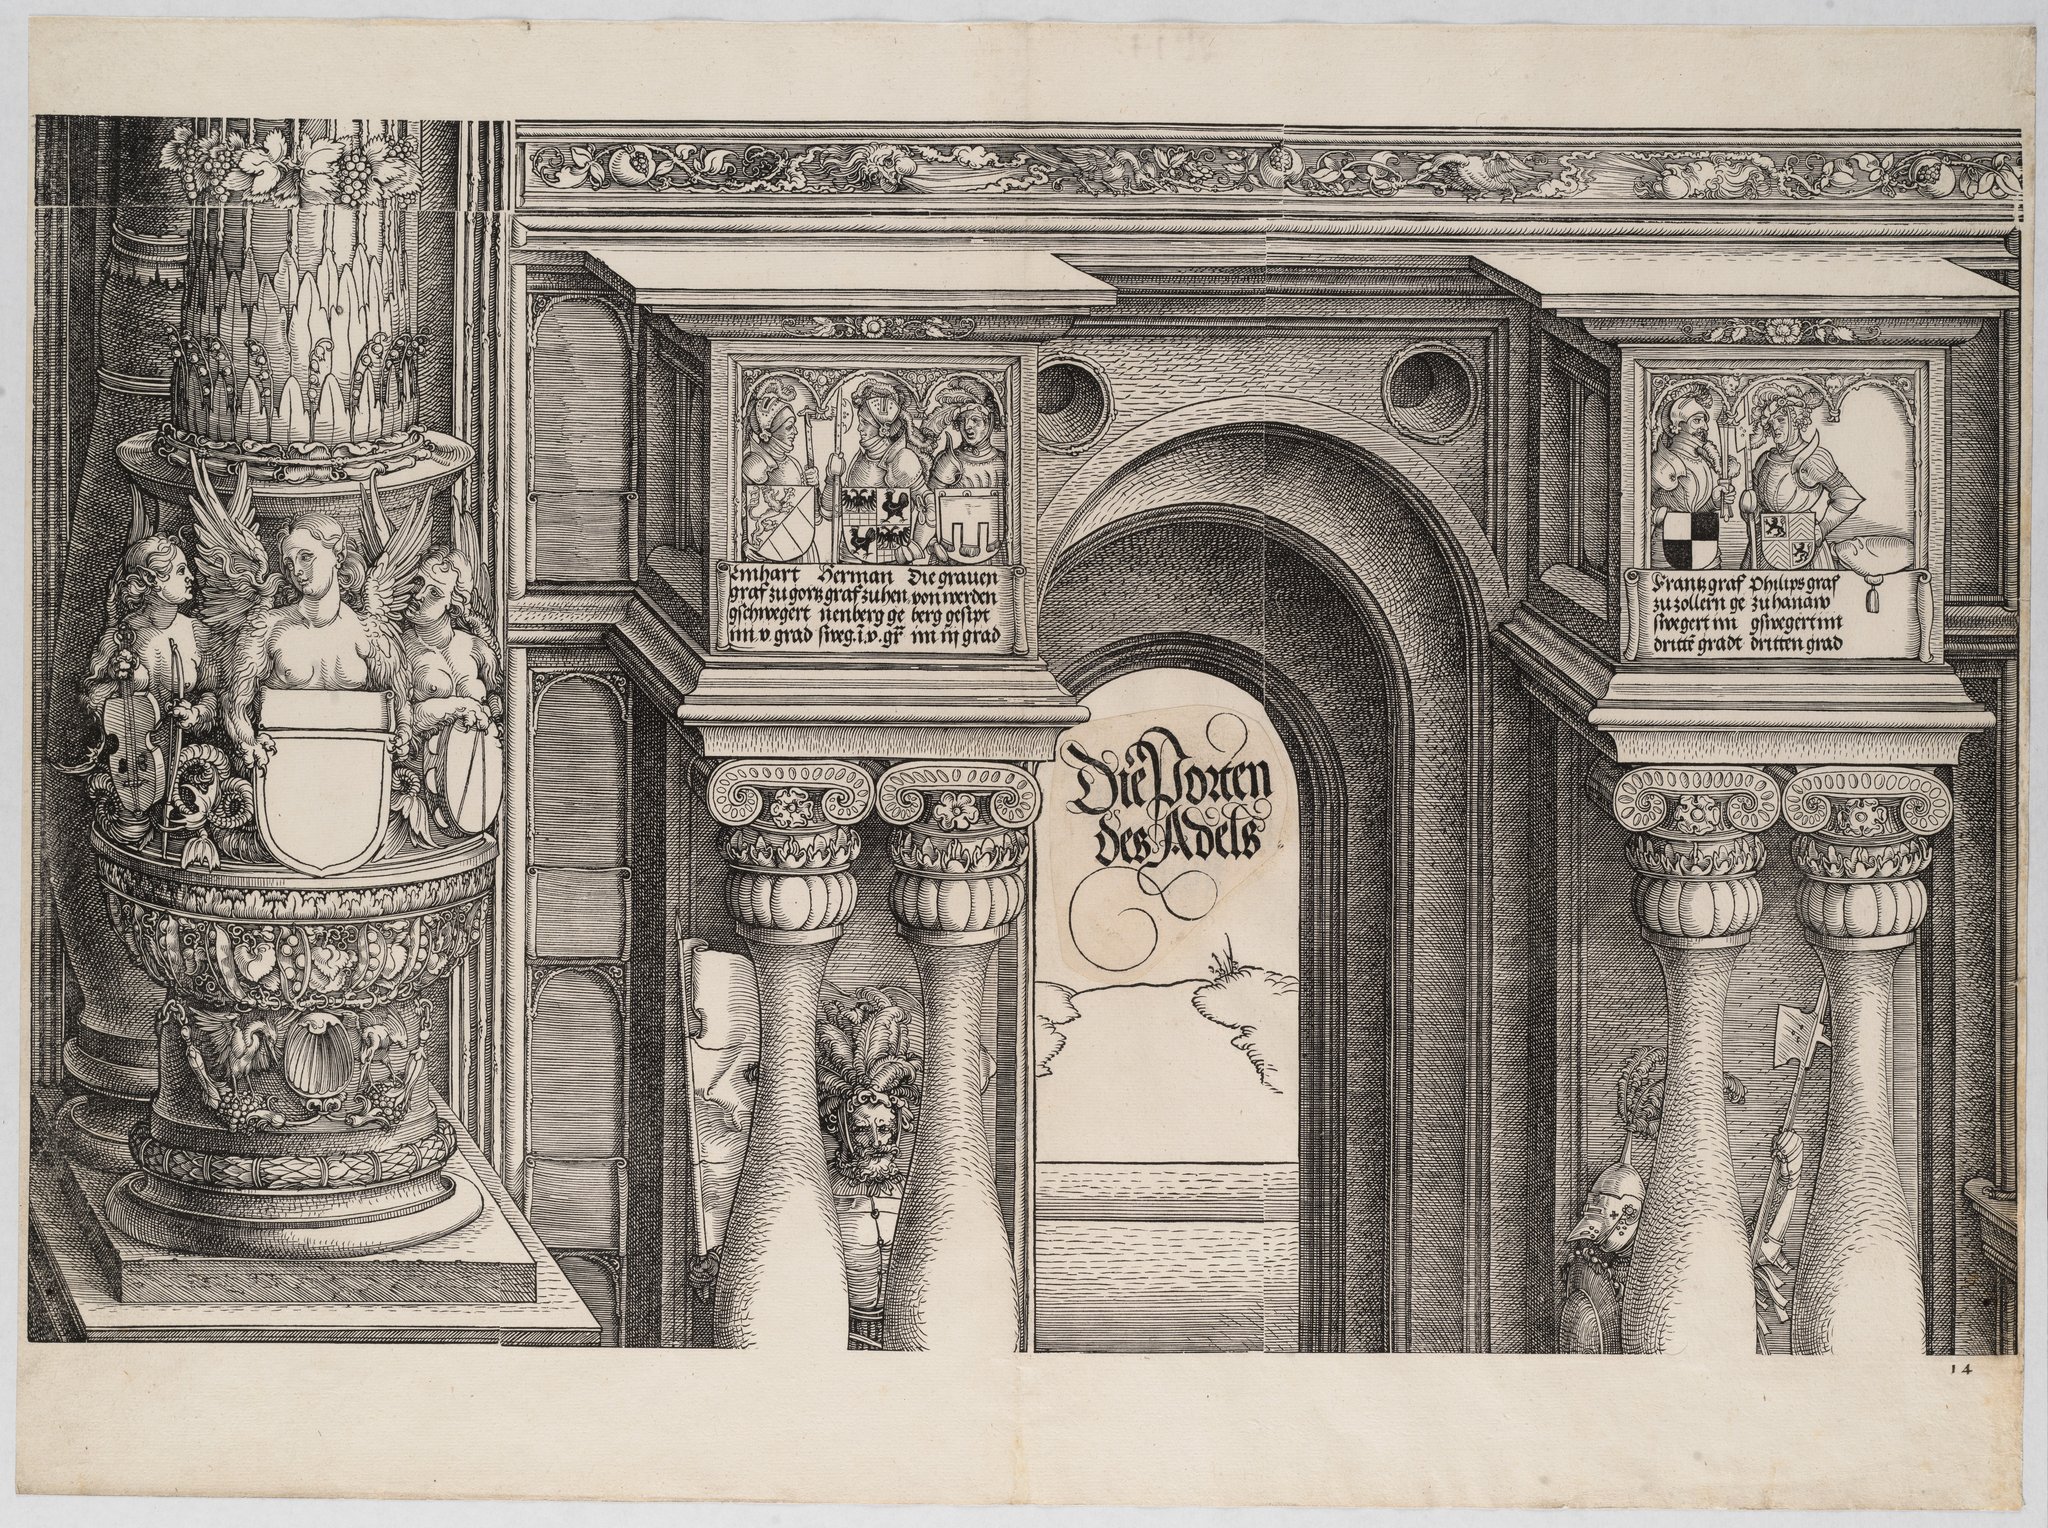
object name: print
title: The Arch in the Entryway of the Right Portal (Die Porten des Adels); and the Outer Right Column of the Central Portal, from the Arch of Honor, proof, dated 1515, printed 1517-18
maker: albrecht dürer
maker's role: artist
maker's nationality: german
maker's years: 1471-1528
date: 1515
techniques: letterpress, woodcut